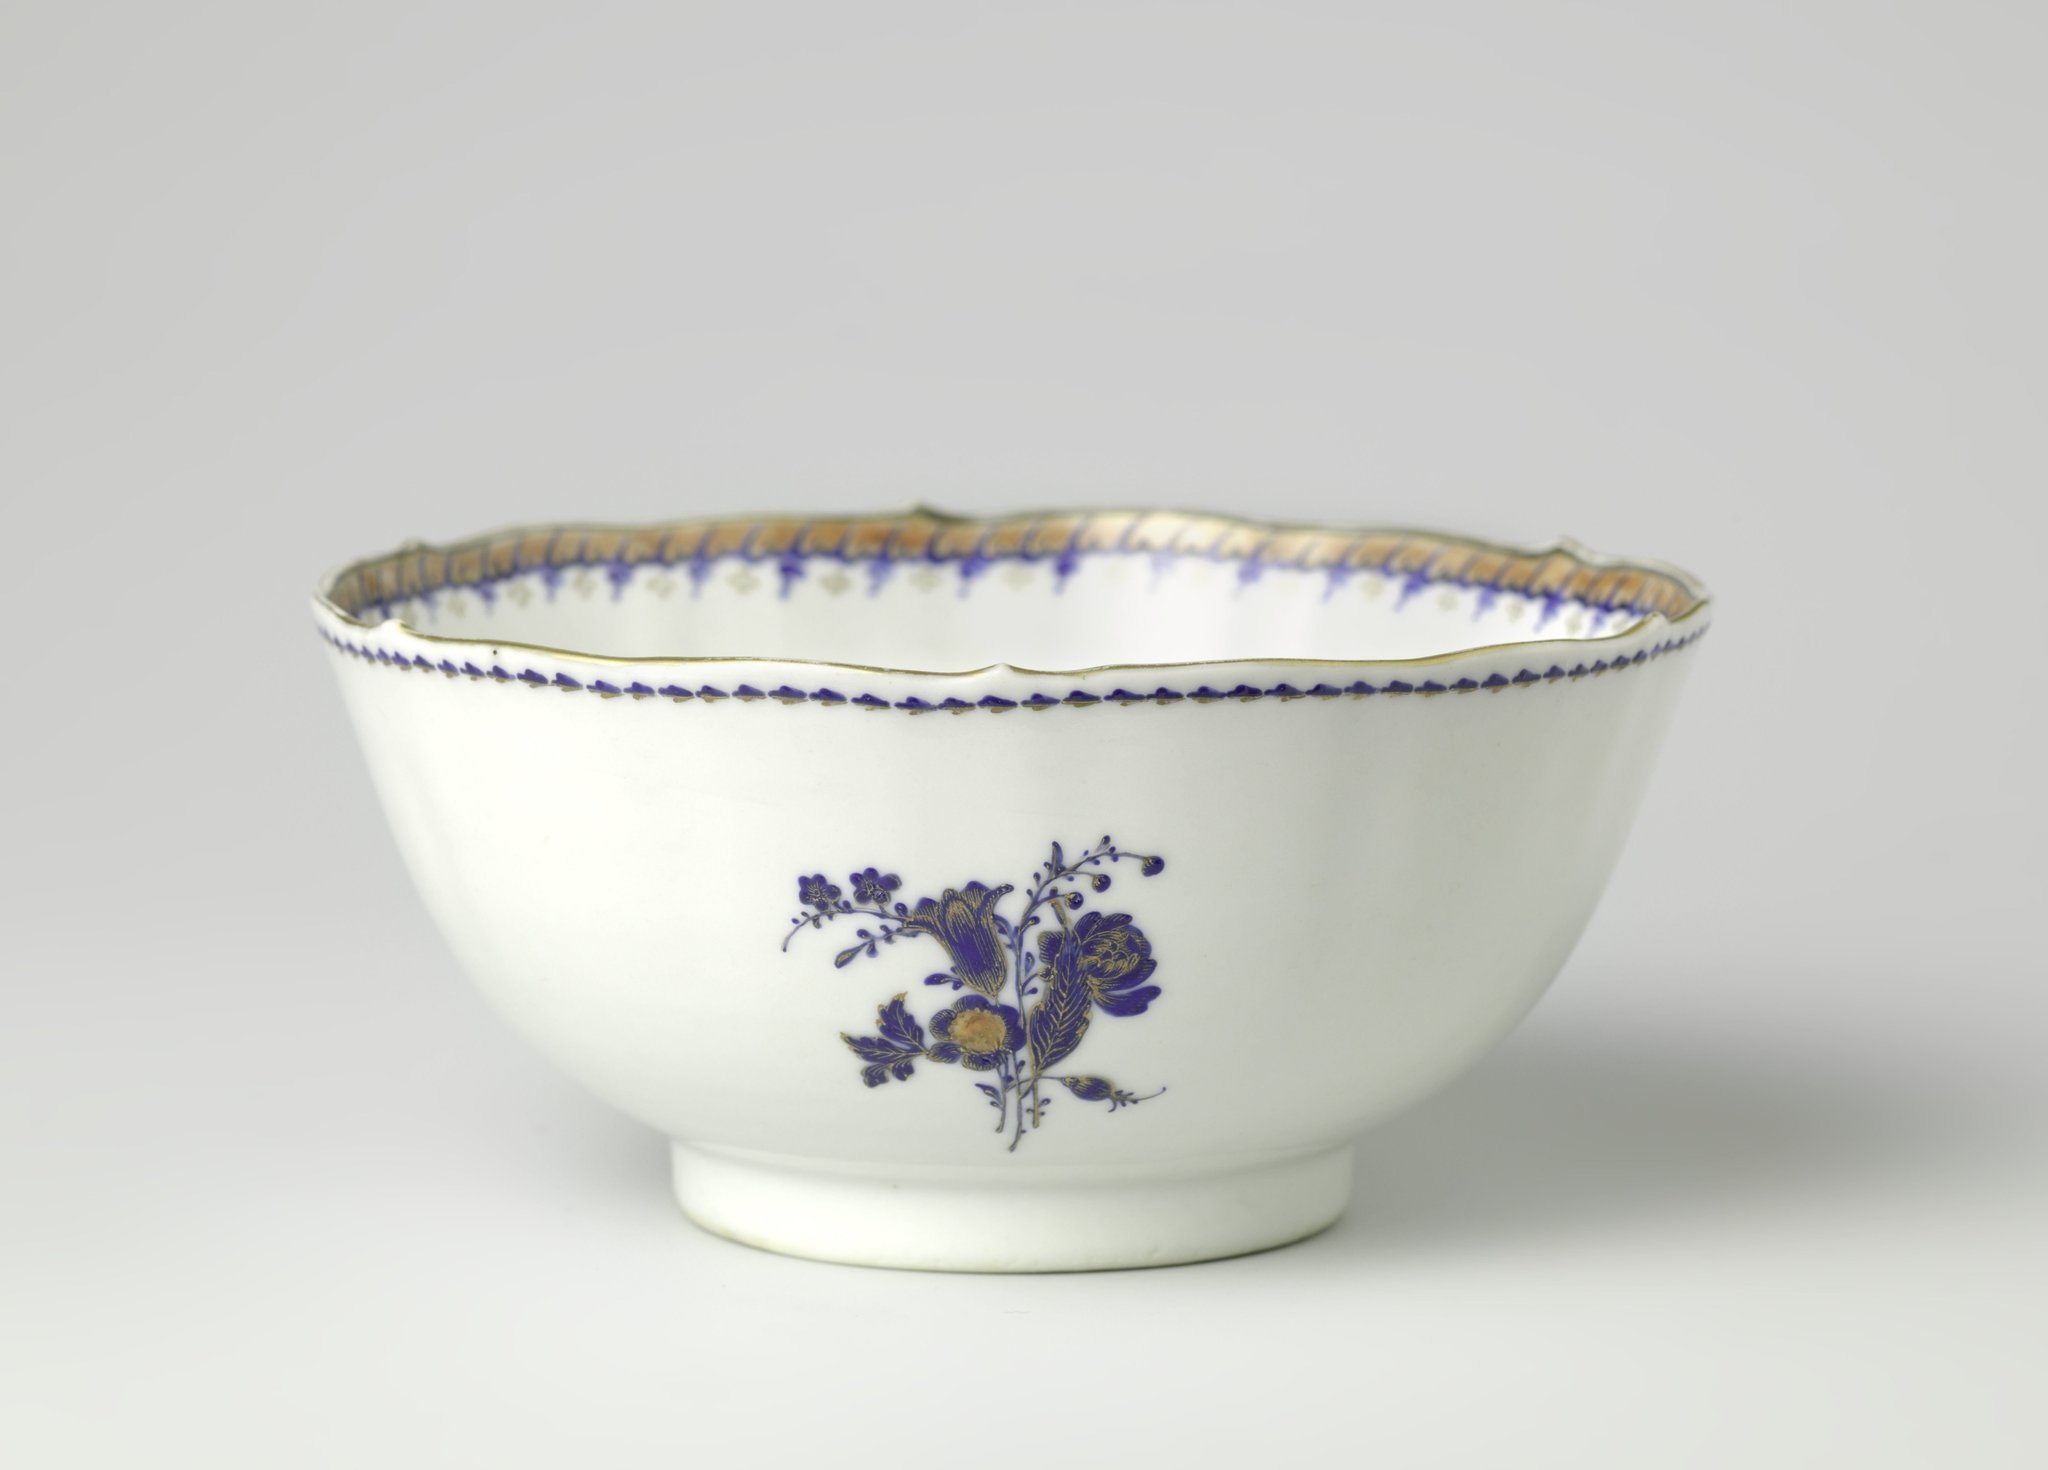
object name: cup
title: Straight-sided cup with two small flower groups and ornamental border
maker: Anonymous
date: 1775-1799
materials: glaze, gold, paint, porcelain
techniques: firing, forming, gilding, turning, vitrification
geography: china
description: Kom van porselein versierd met randen van blauw, roze en goud en een enkele bloem.